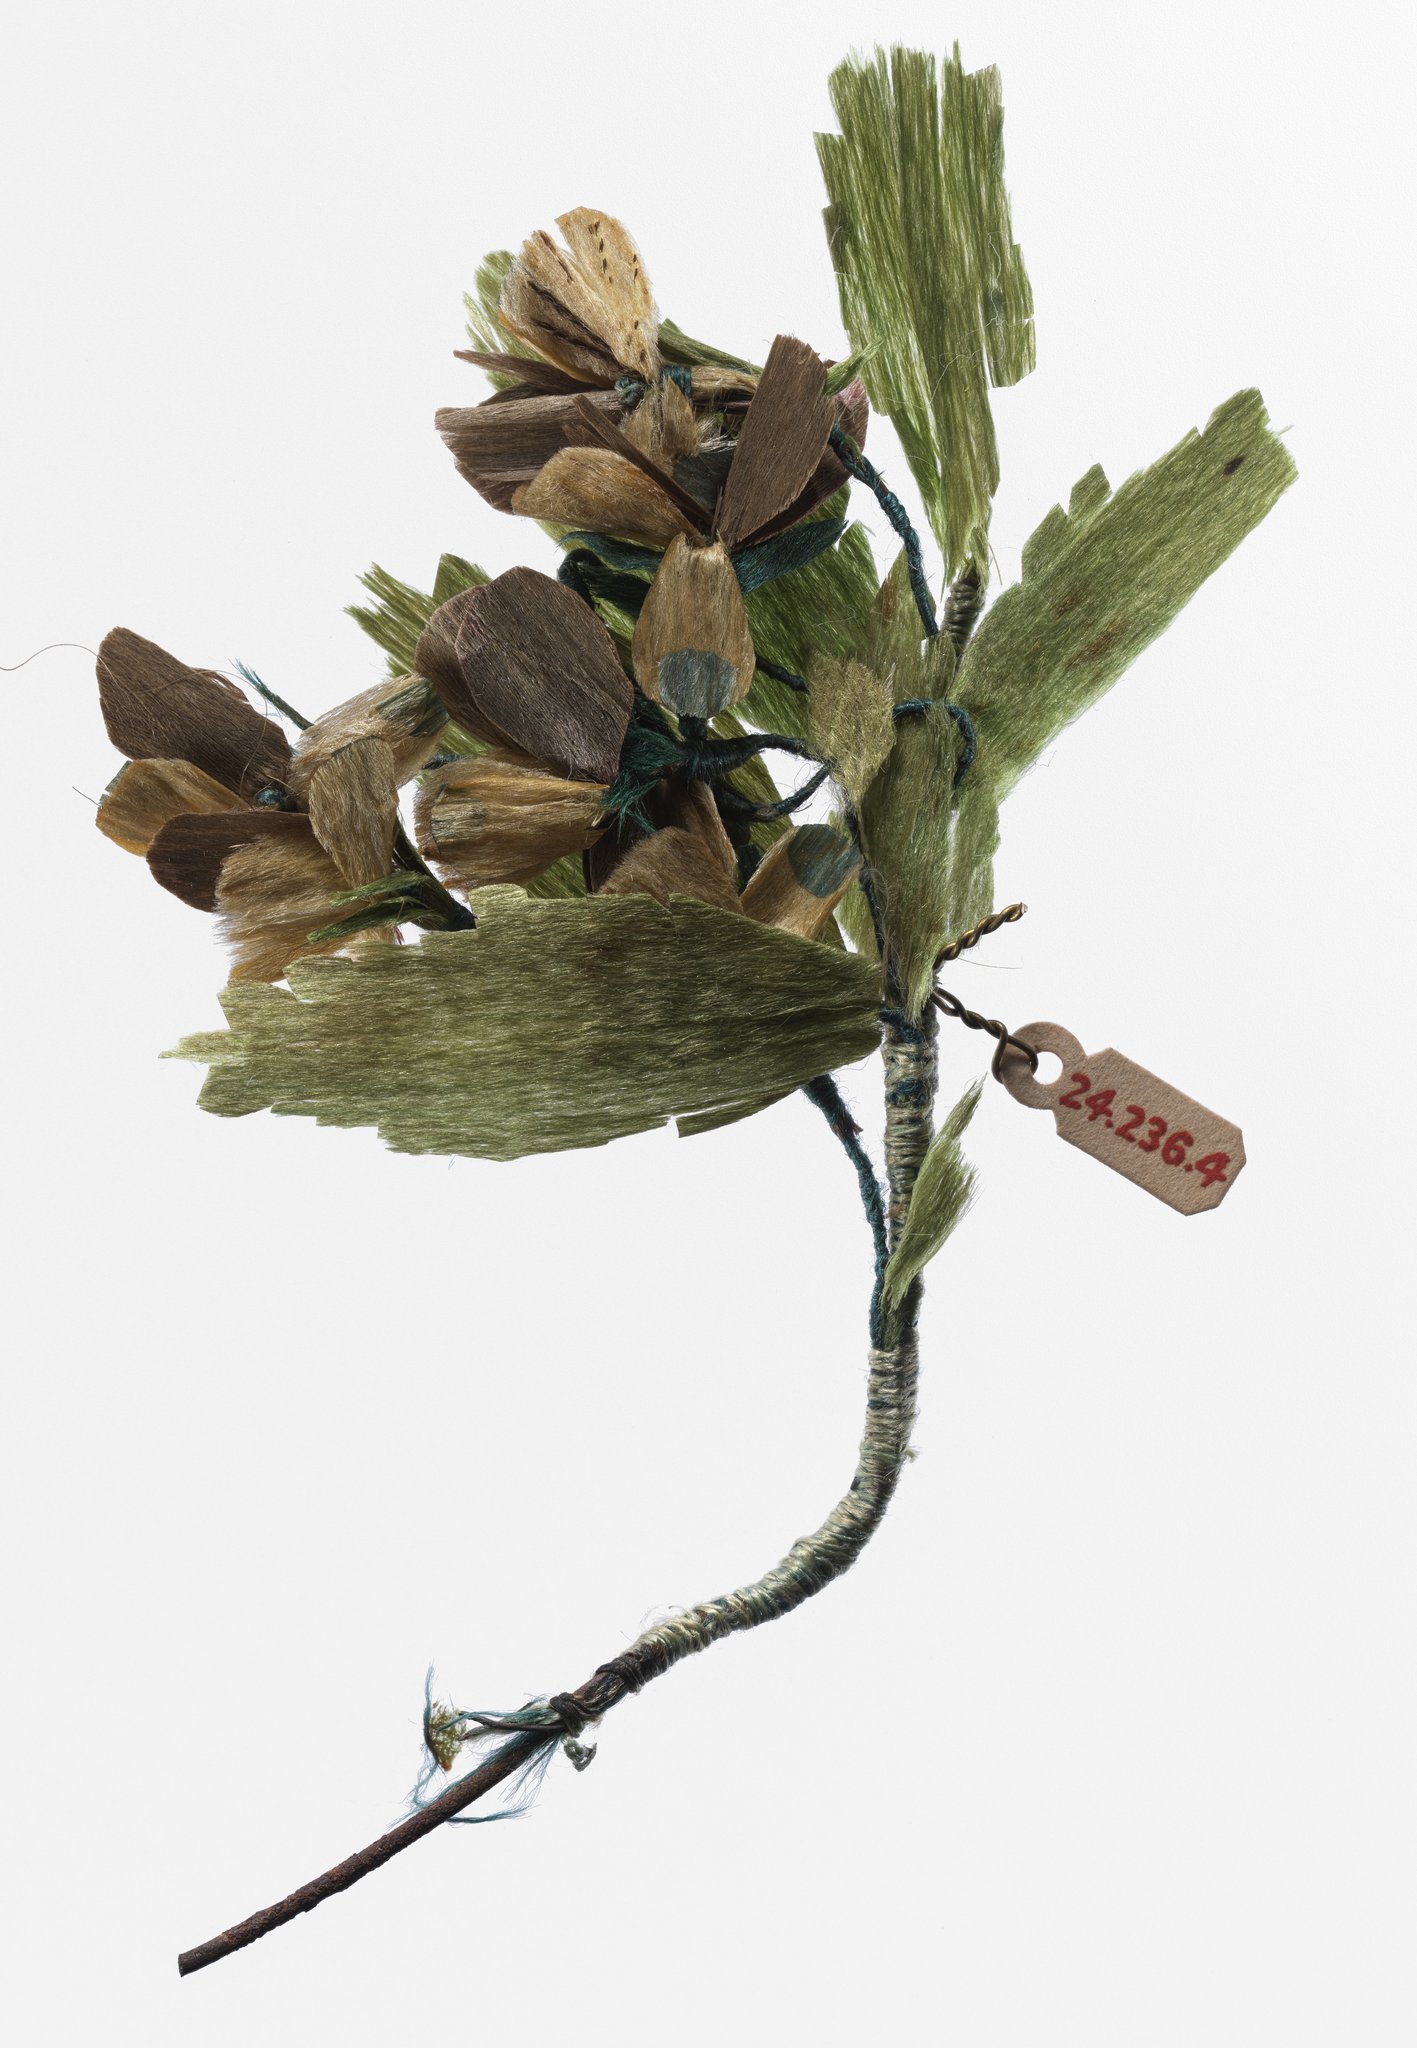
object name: boutonnière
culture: british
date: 1625-1649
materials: silk